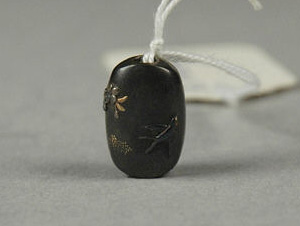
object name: ojime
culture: japanese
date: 1801-1900